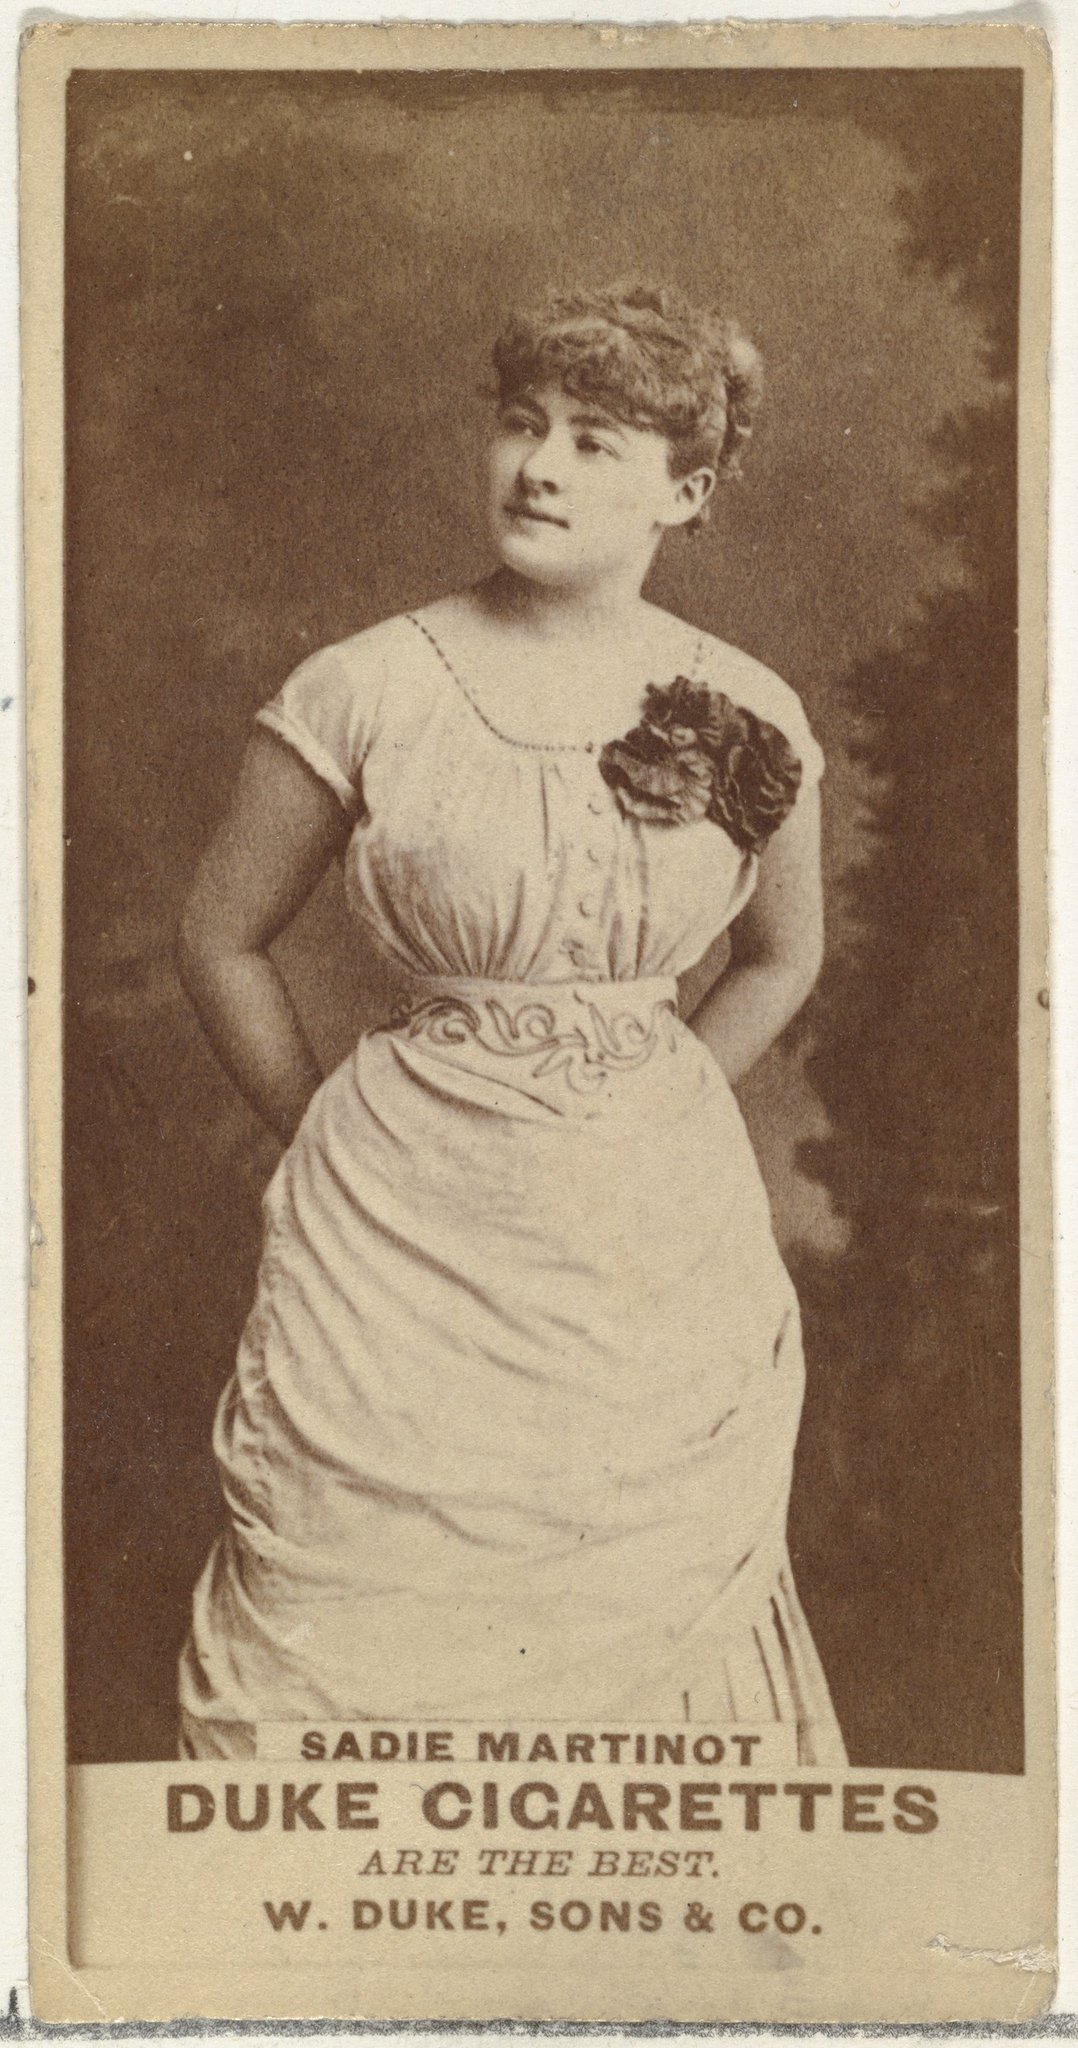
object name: photograph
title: Sadie Martinot, from the Actors and Actresses series (N145-7) issued by Duke Sons & Co. to promote Duke Cigarettes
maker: w. duke, sons & co.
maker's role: publisher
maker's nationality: american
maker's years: 1870-1920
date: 1880-1889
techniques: albumen silver print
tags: portraits,women,actresses